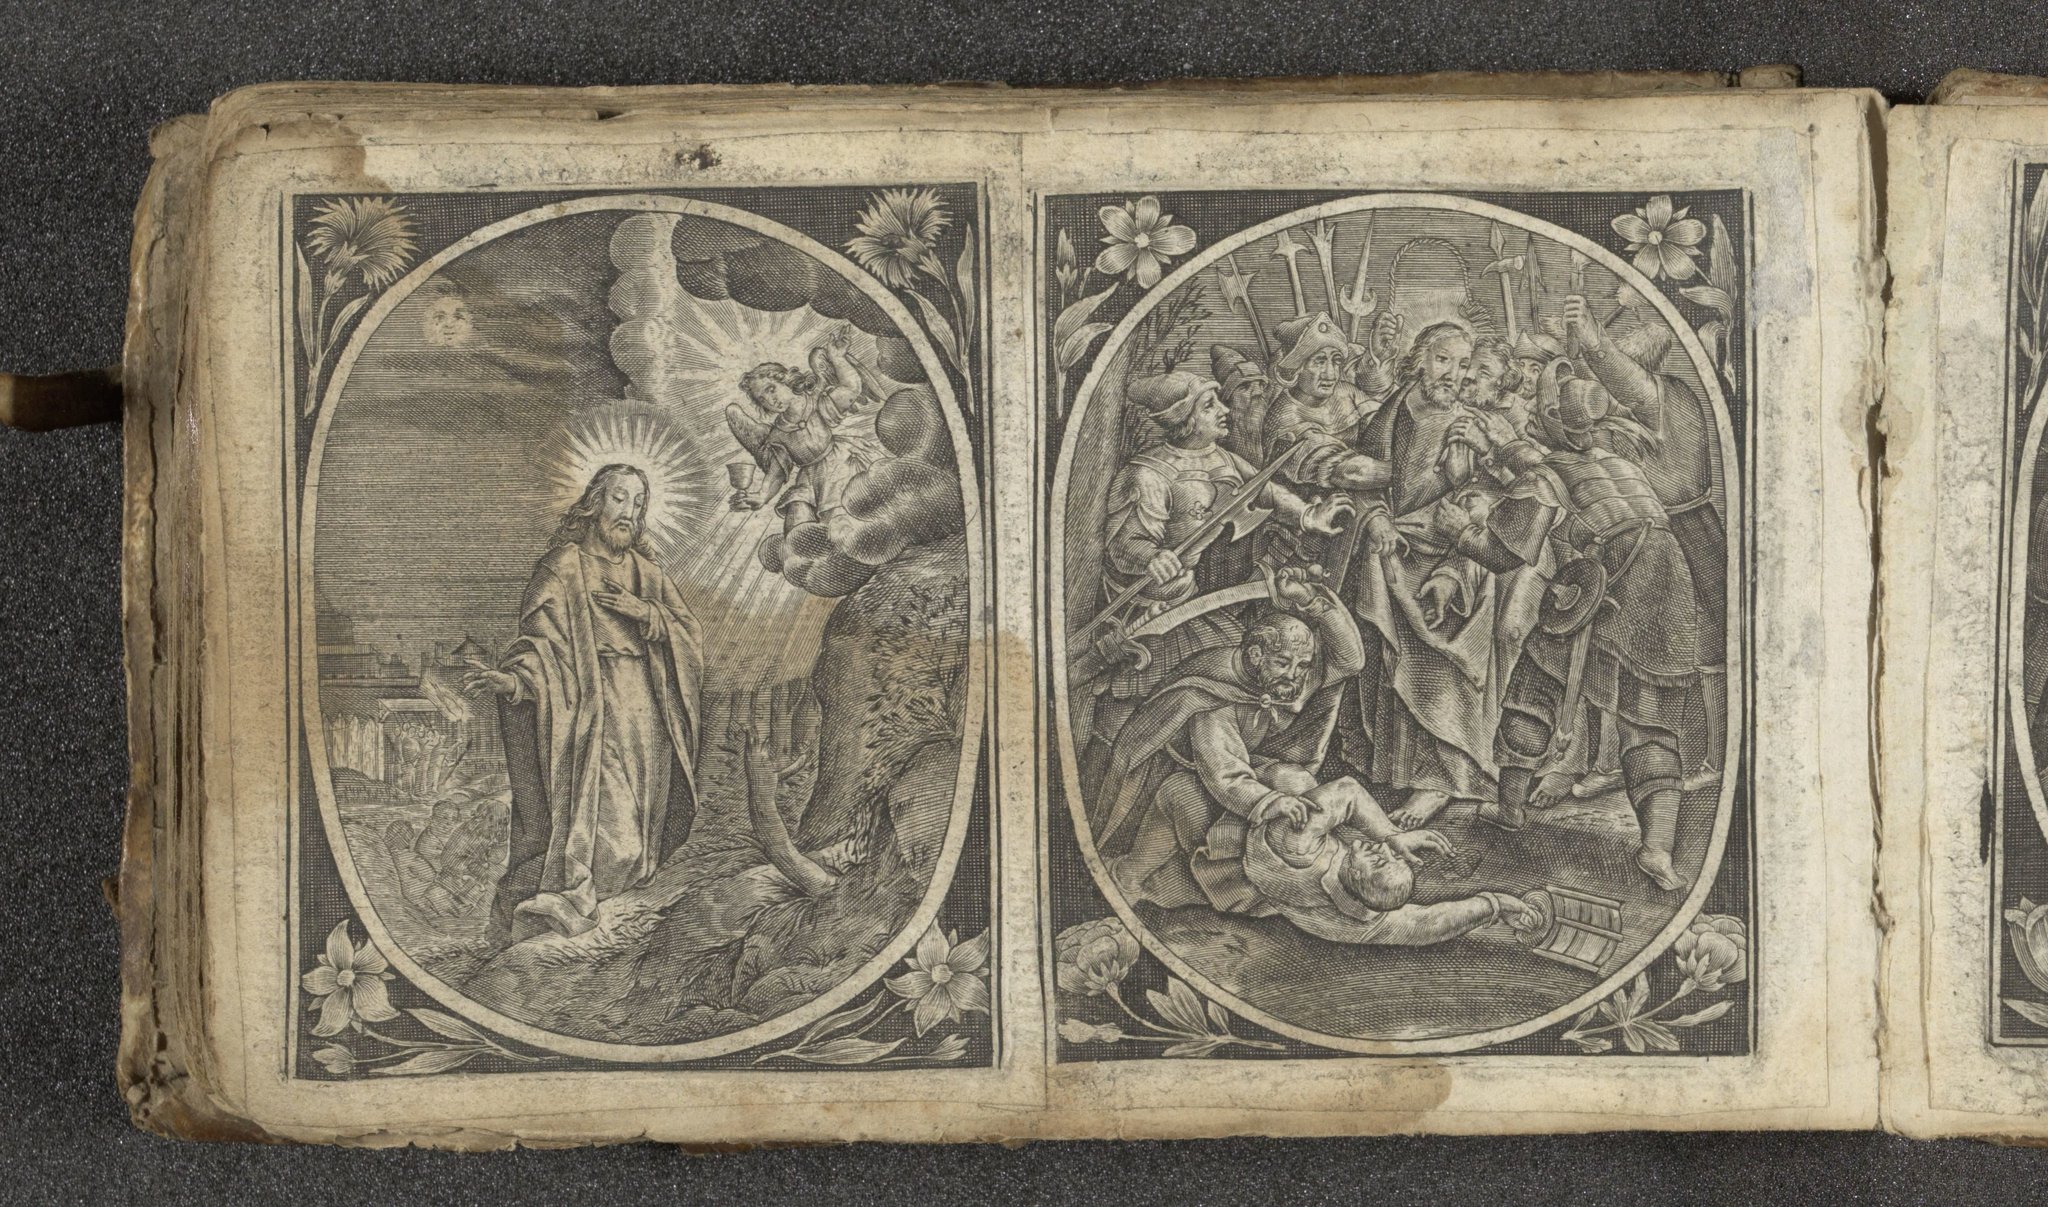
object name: print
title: Passie van Christus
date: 1576-1650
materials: paper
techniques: engraving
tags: peter draws his sword and cuts off malchus' ear, the kiss of judas: accompanied by soldiers with torches and lanterns, he kisses christ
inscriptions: inscription: ‘87’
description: Judas kust Christus op de wang. De soldaten omsingelen en arresteren hem. Petrus staat op het punt het oor van Malchus af te hakken. Ovaal binnen een rechthoekig kader, in elke hoek een bloem. De prent maakt deel uit van een album.